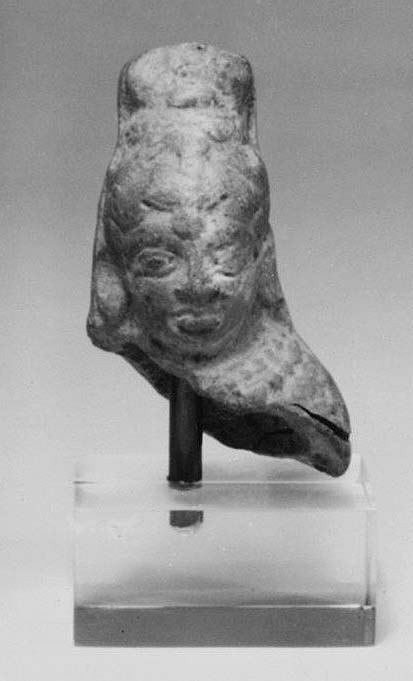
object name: head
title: Head of a Female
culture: indian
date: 101-200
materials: terracotta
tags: satavahana,heads,women